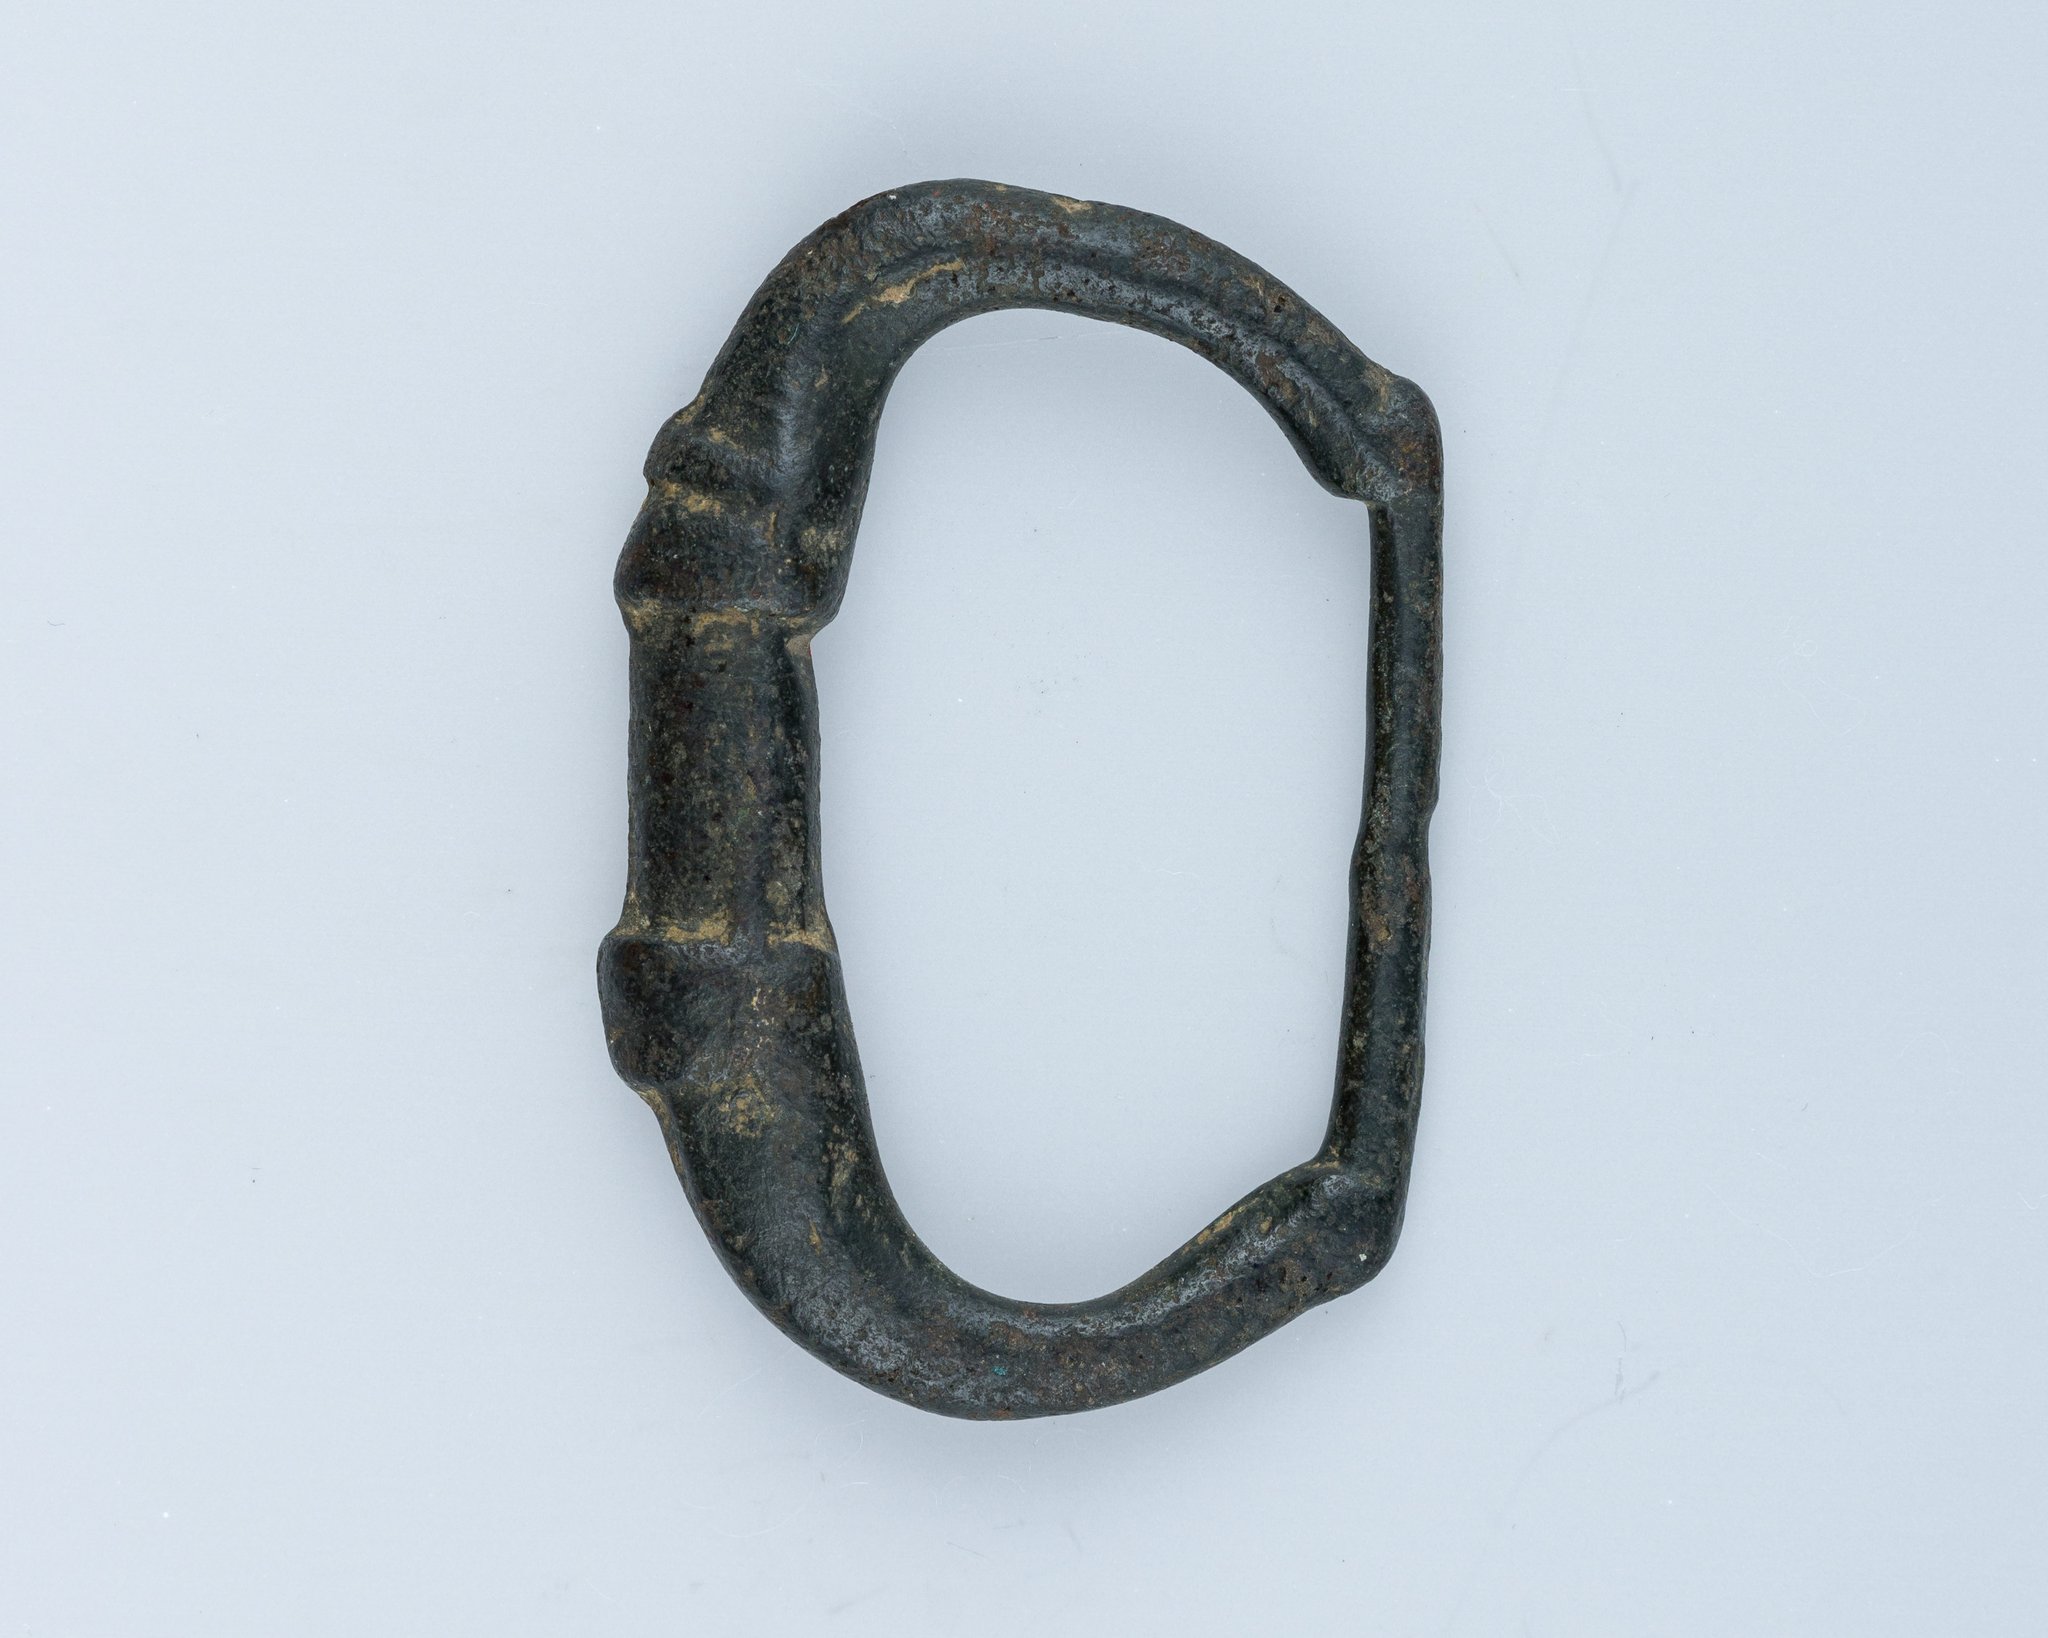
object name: buckle loop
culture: french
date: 1501-1600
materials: bronze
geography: france